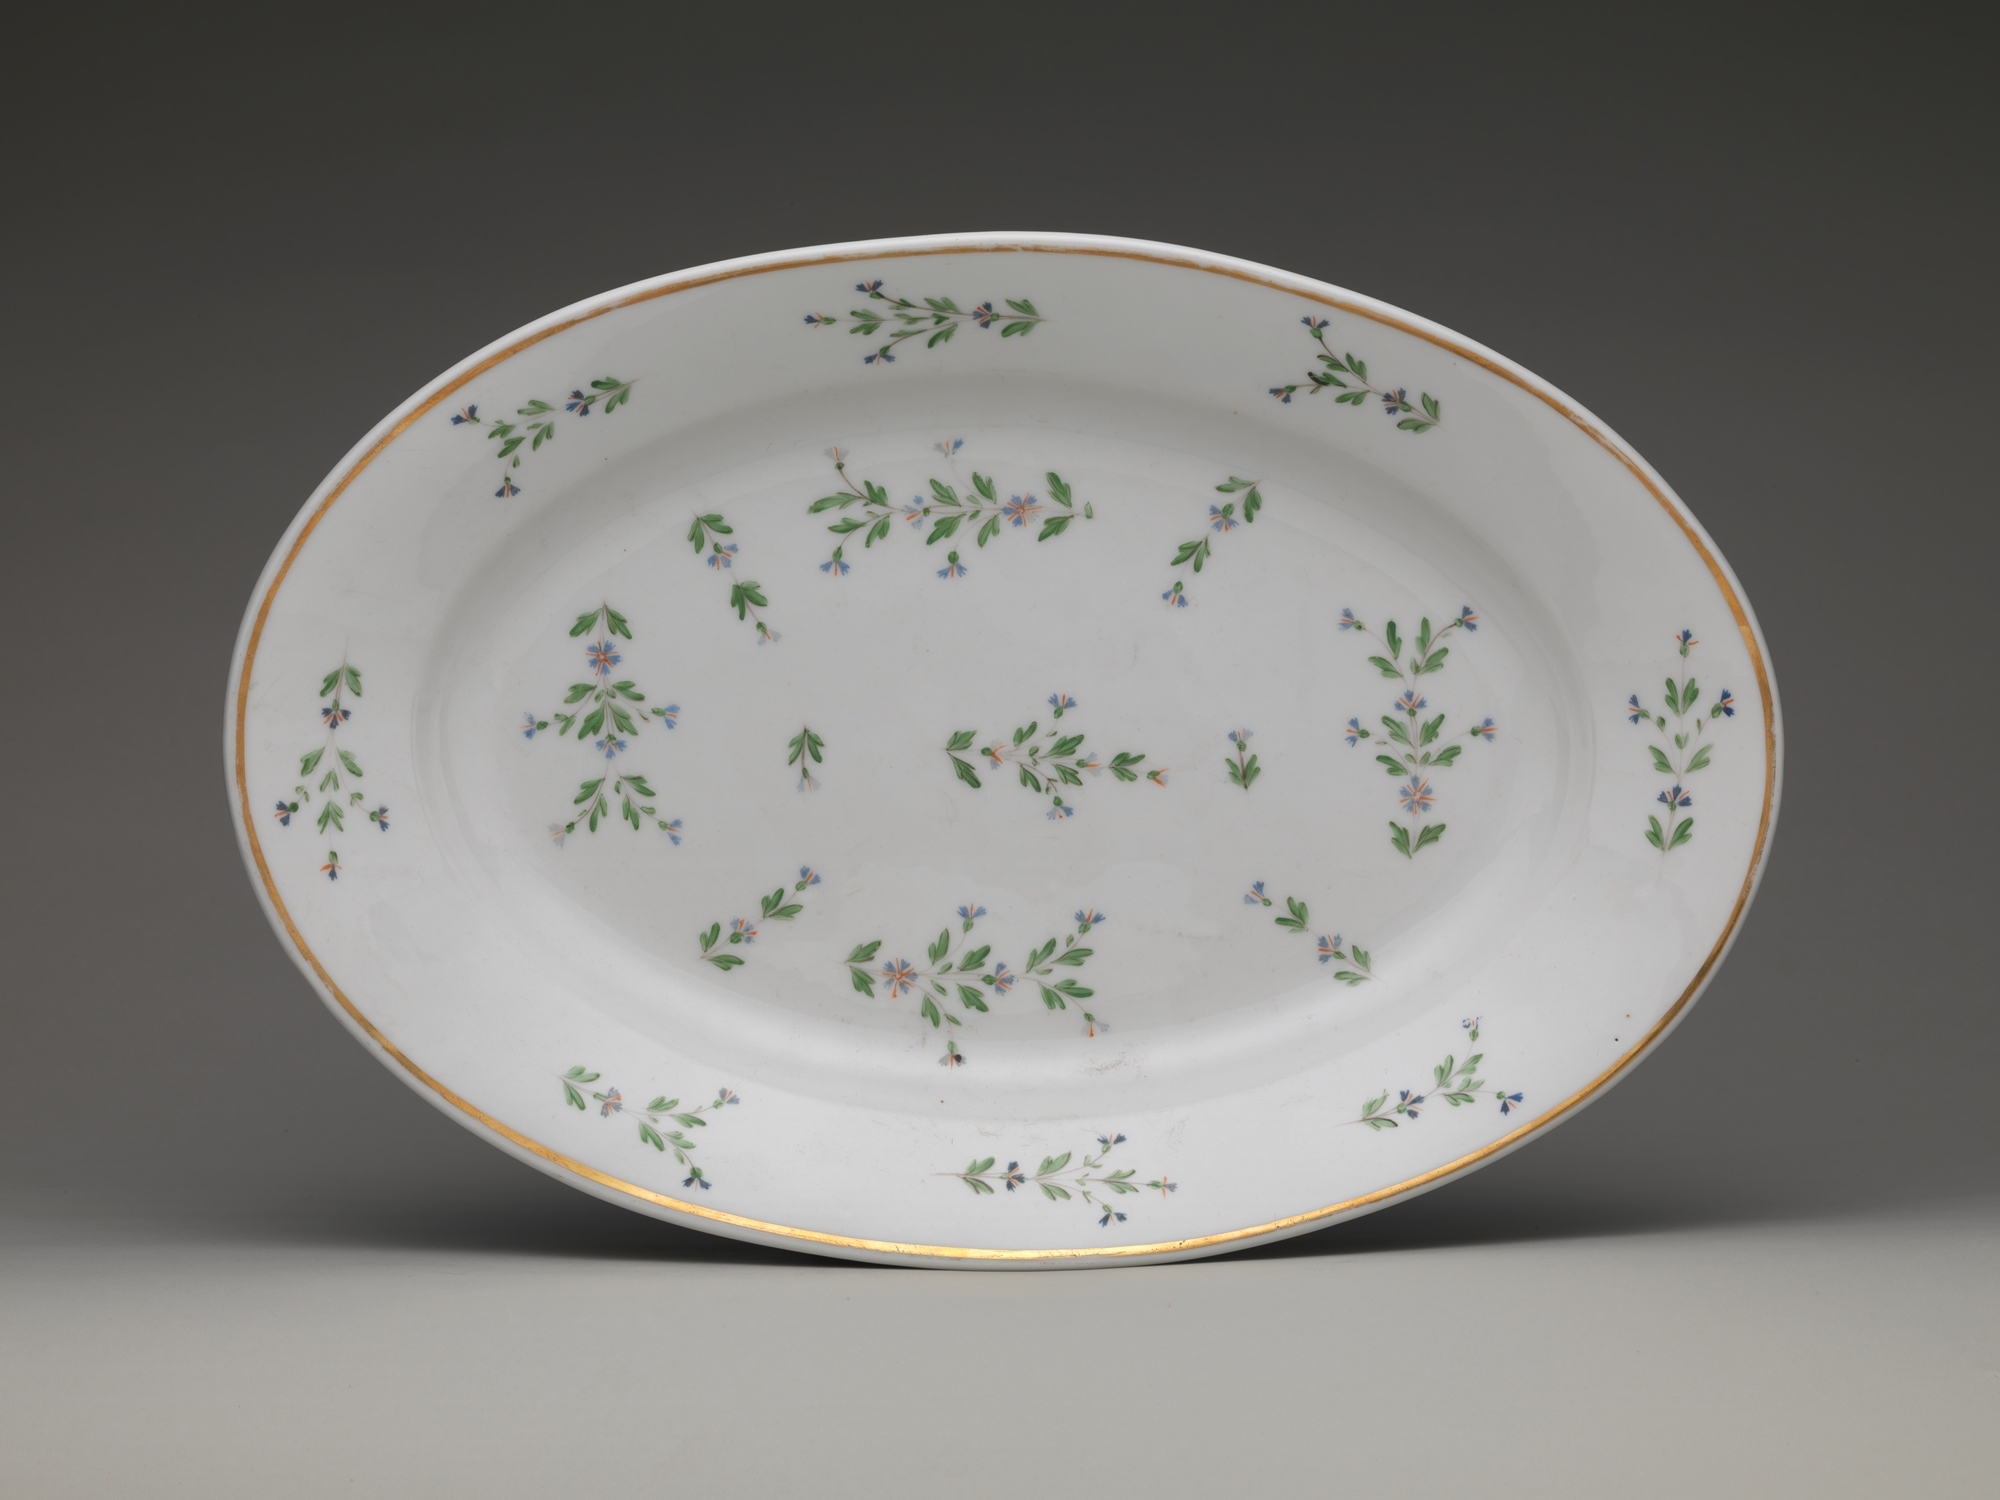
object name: platter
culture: french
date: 1815-1830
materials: porcelain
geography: france